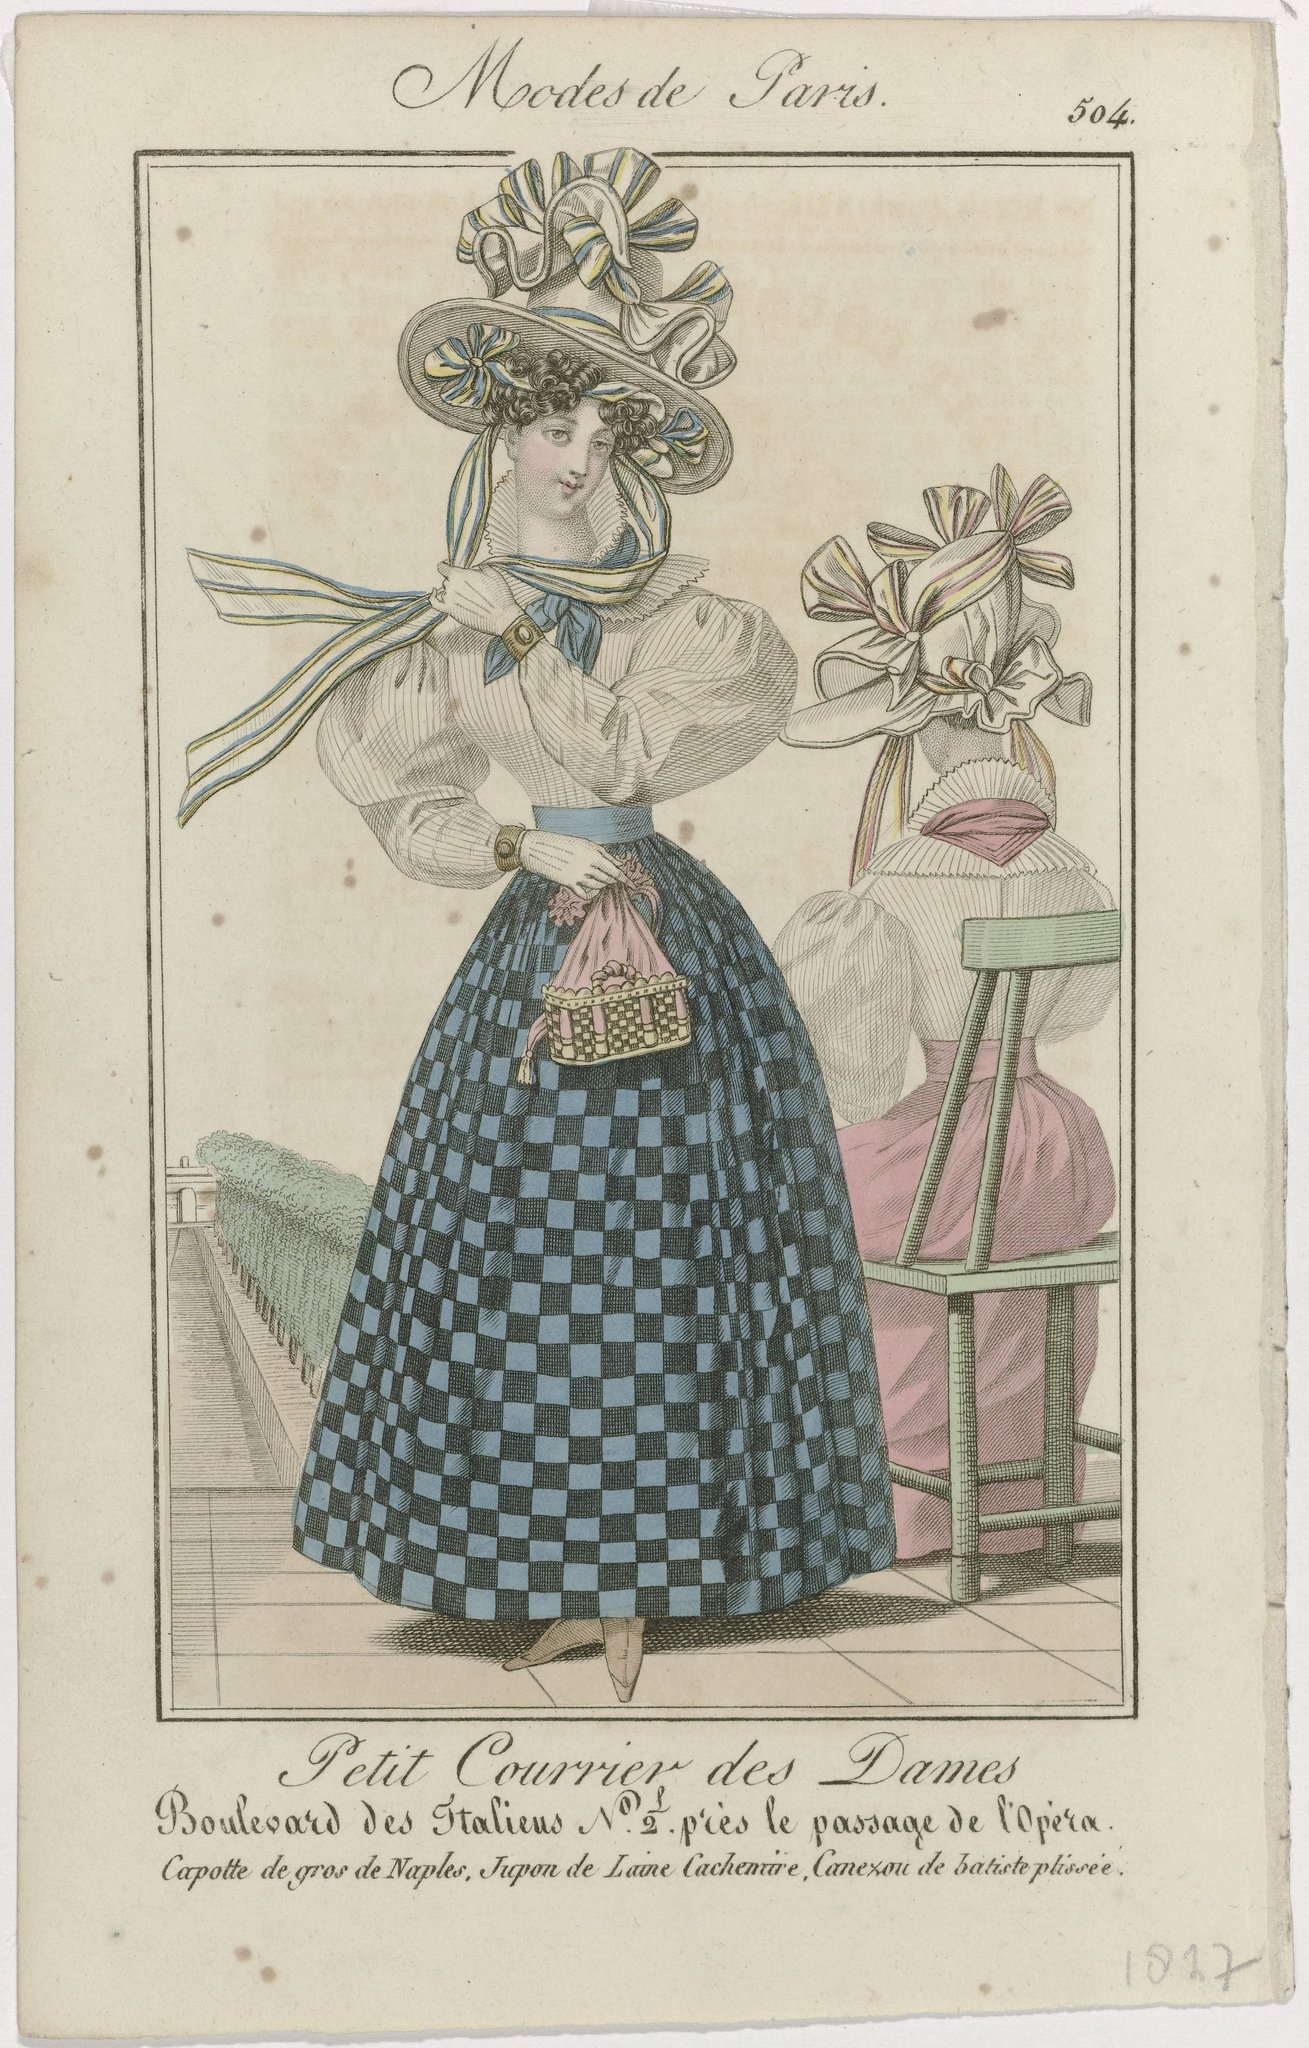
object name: fashion print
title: Petit Courrier des Dames, 1827, No. 504 : Capotte de gros de Naples (...)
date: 1827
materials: paper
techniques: engraving, hand coloring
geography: paris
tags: head-gear (capote) (+ women's clothes), clothing for the upper part of the body: blouse (+ women's clothes), bag (handbag) (+ women's clothes), boots (+ women's clothes), fashion plates, skirt (+ women's clothes), gloves, mittens, etc. (+ women's clothes), neck-gear ~ clothing (+ women's clothes), bracelet, wristlet (+ women's clothes)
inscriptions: caption, title: ‘Petit Courrier des Dames.’, caption: ‘Capotte de gros de Naples, Jupon de Laine Cachemire, Canezou de batiste plissée.’, title: ‘Modes de Paris.’, address: ‘Boulevard des Italiens No.2 près le passage de l'Opèra.’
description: Capote van 'gros de Naples'. Rok van 'laine cachemire'. Canezou van geplooide batist. Verdere accessoires: geknoopte halsdoek, handschoenen, armbanden om beide polsen, tasje of mandje, laarzen. Prent uit het modetijdschrift Petit Courrier des Dames (1821-1868).